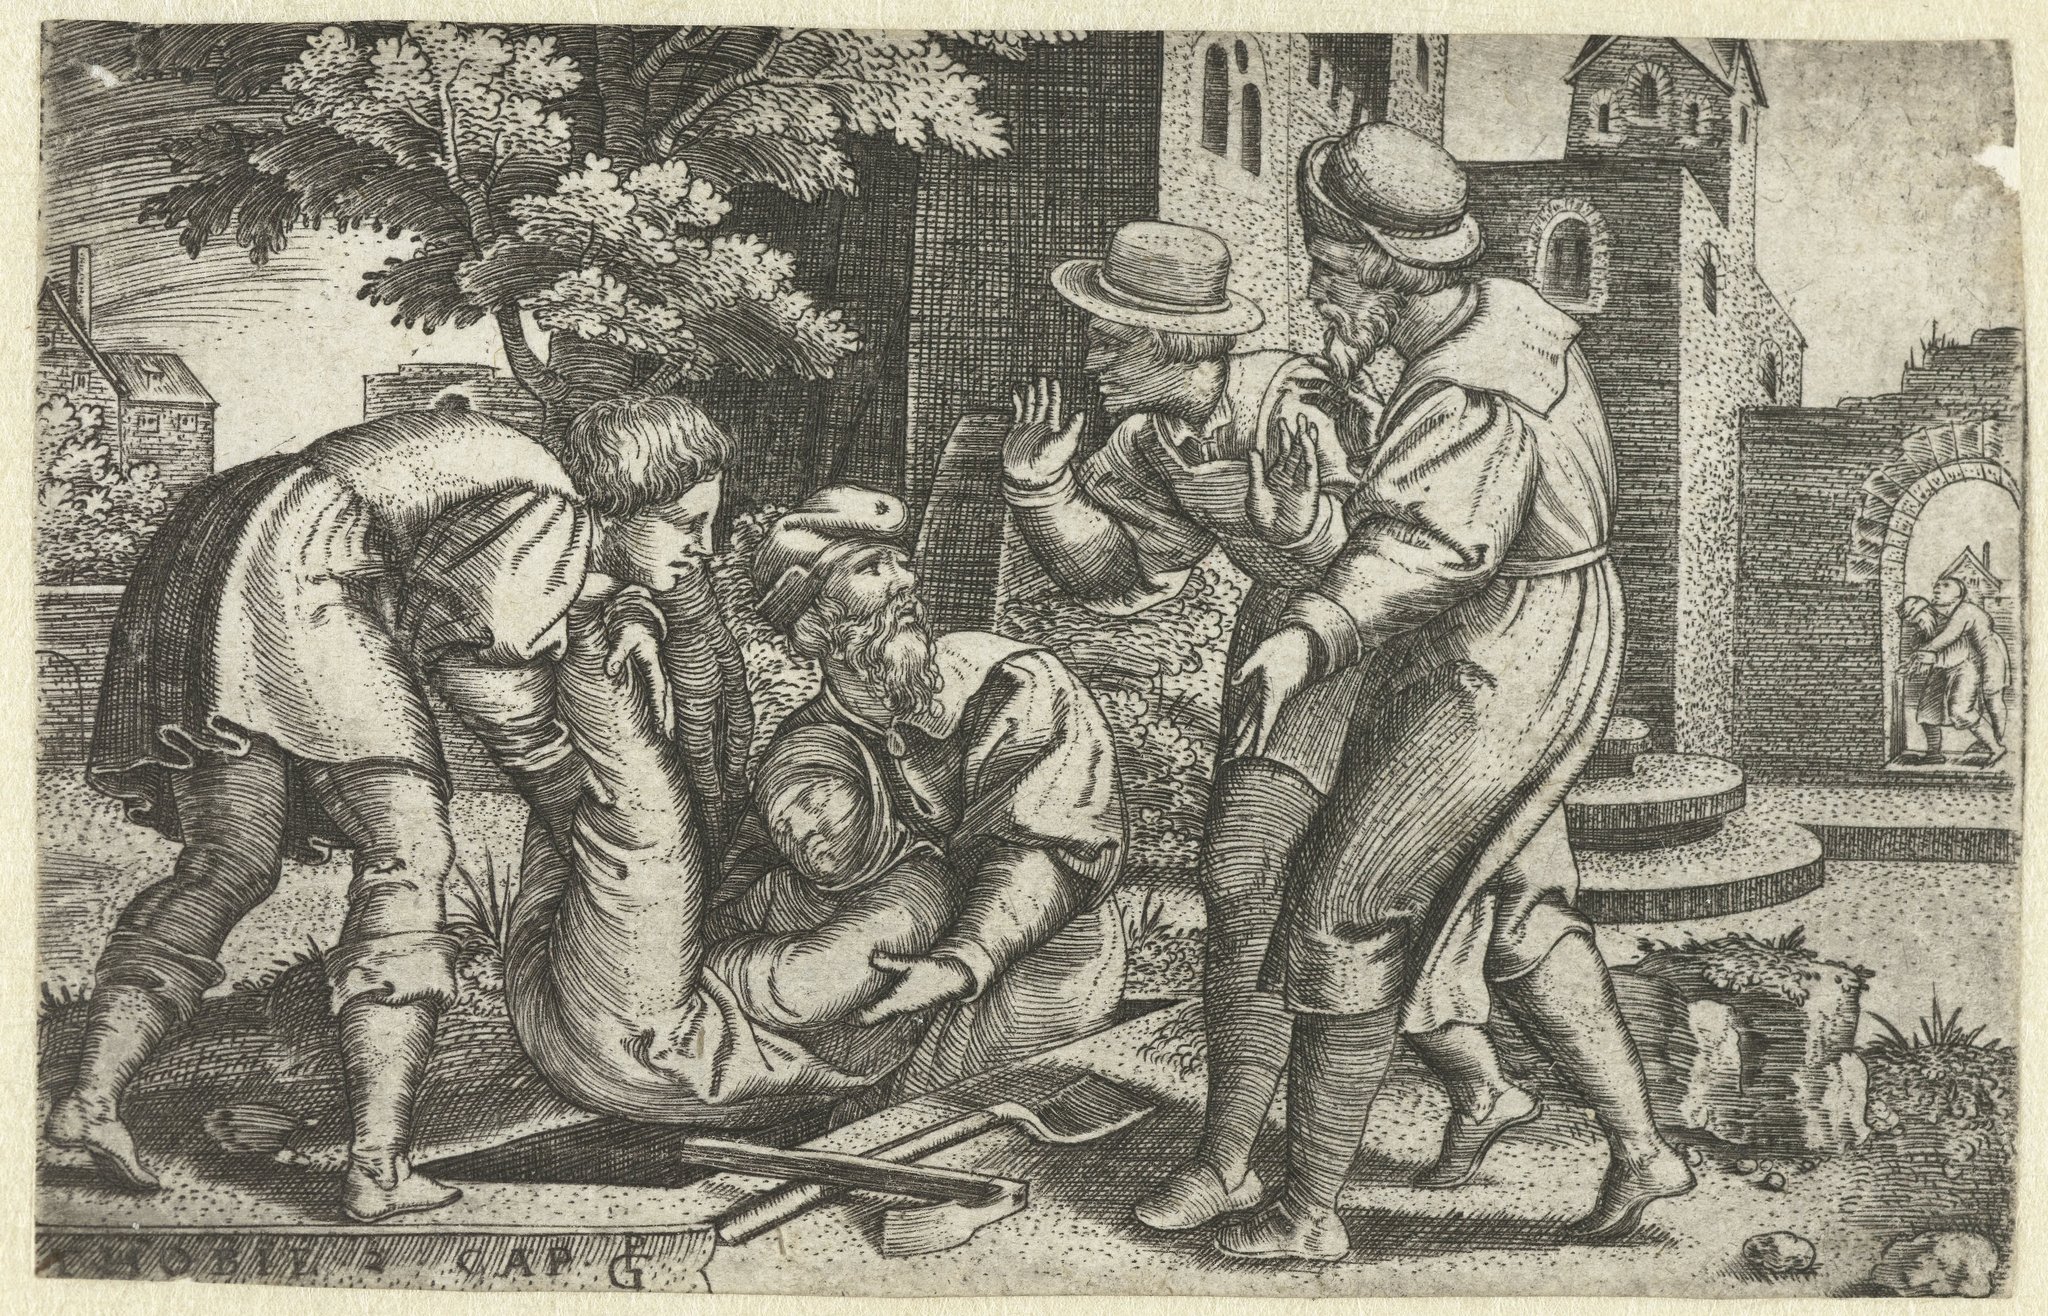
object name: print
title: Tobit en Tobias begraven een lichaam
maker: georg pencz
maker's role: draughtsman, painter, print maker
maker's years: 1500-1550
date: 1543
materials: paper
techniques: engraving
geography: germany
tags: tobit buries a dead man at night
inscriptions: collector's mark: ‘Hinlooopen’ Lugt 11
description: Tobit en Tobias begraven het lichaam van een man die is gewurgd in opdracht van de Assyrische koning. Tobit wordt bespot door twee mannen over het ontbreken van zijn angst om betrapt te worden. Volgens de bijbeltekst is Tobias niet aanwezig bij deze gebeurtenis en vindt deze scène plaats bij nacht maar dat blijkt niet uit de voorstelling (Tobit 2: 7-8).